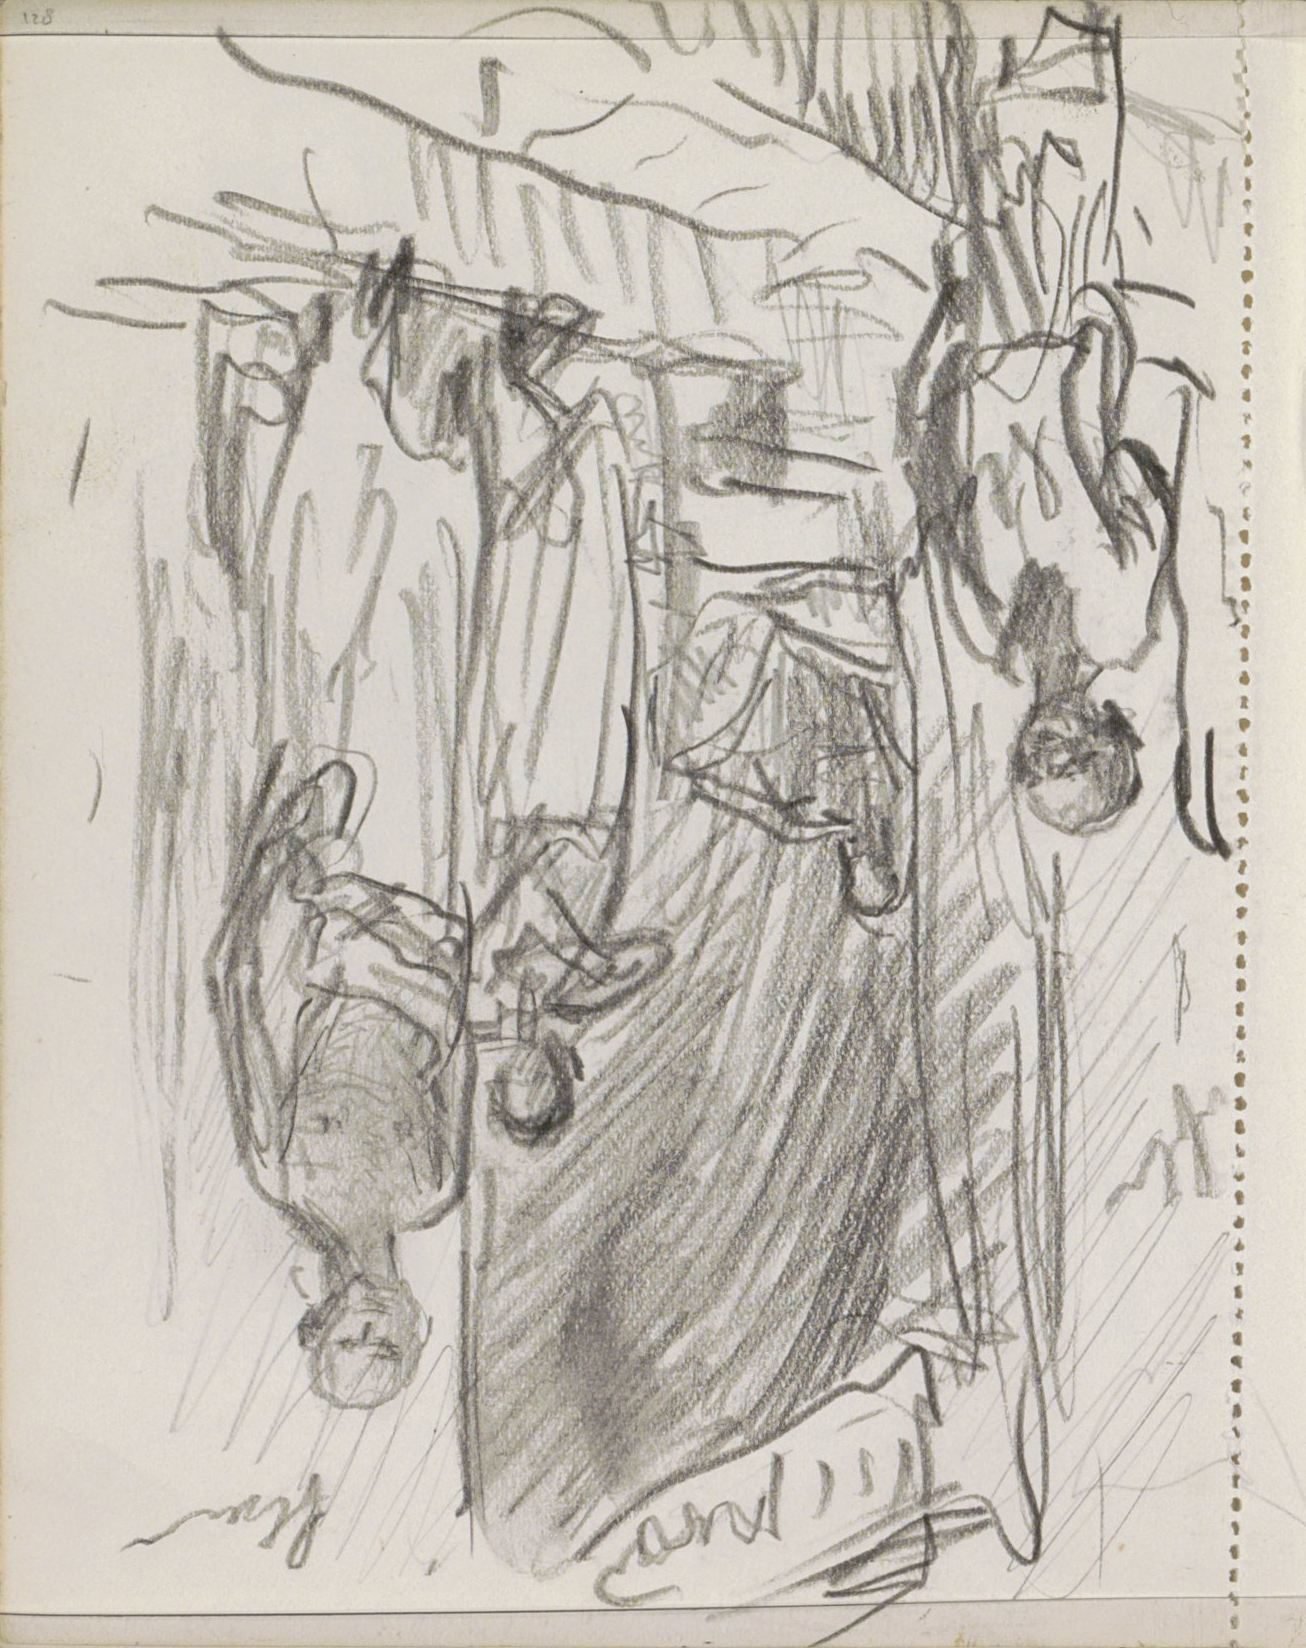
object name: sketchbook leaf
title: Indiërs op een trap bij een deuropening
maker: marius bauer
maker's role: draughtsman, print maker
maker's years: 1867-1932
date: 1924-1925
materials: chalk, paper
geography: india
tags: standing figure, open door, asiatic races and peoples: indians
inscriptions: kleurnotitie, handgeschreven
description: Pagina 128 uit een schetsboek met 75 bladen.